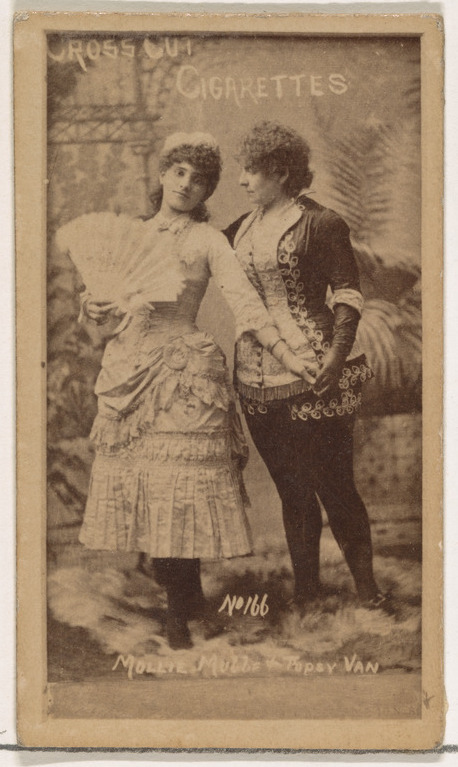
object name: print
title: Card Number 166, from the Actors and Actresses series (N145-1) issued by Duke Sons & Co. to promote Cross Cut Cigarettes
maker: w. duke, sons & co.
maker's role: publisher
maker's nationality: american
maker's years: 1870-1920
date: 1880-1889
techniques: albumen silver print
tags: portraits,women,actresses